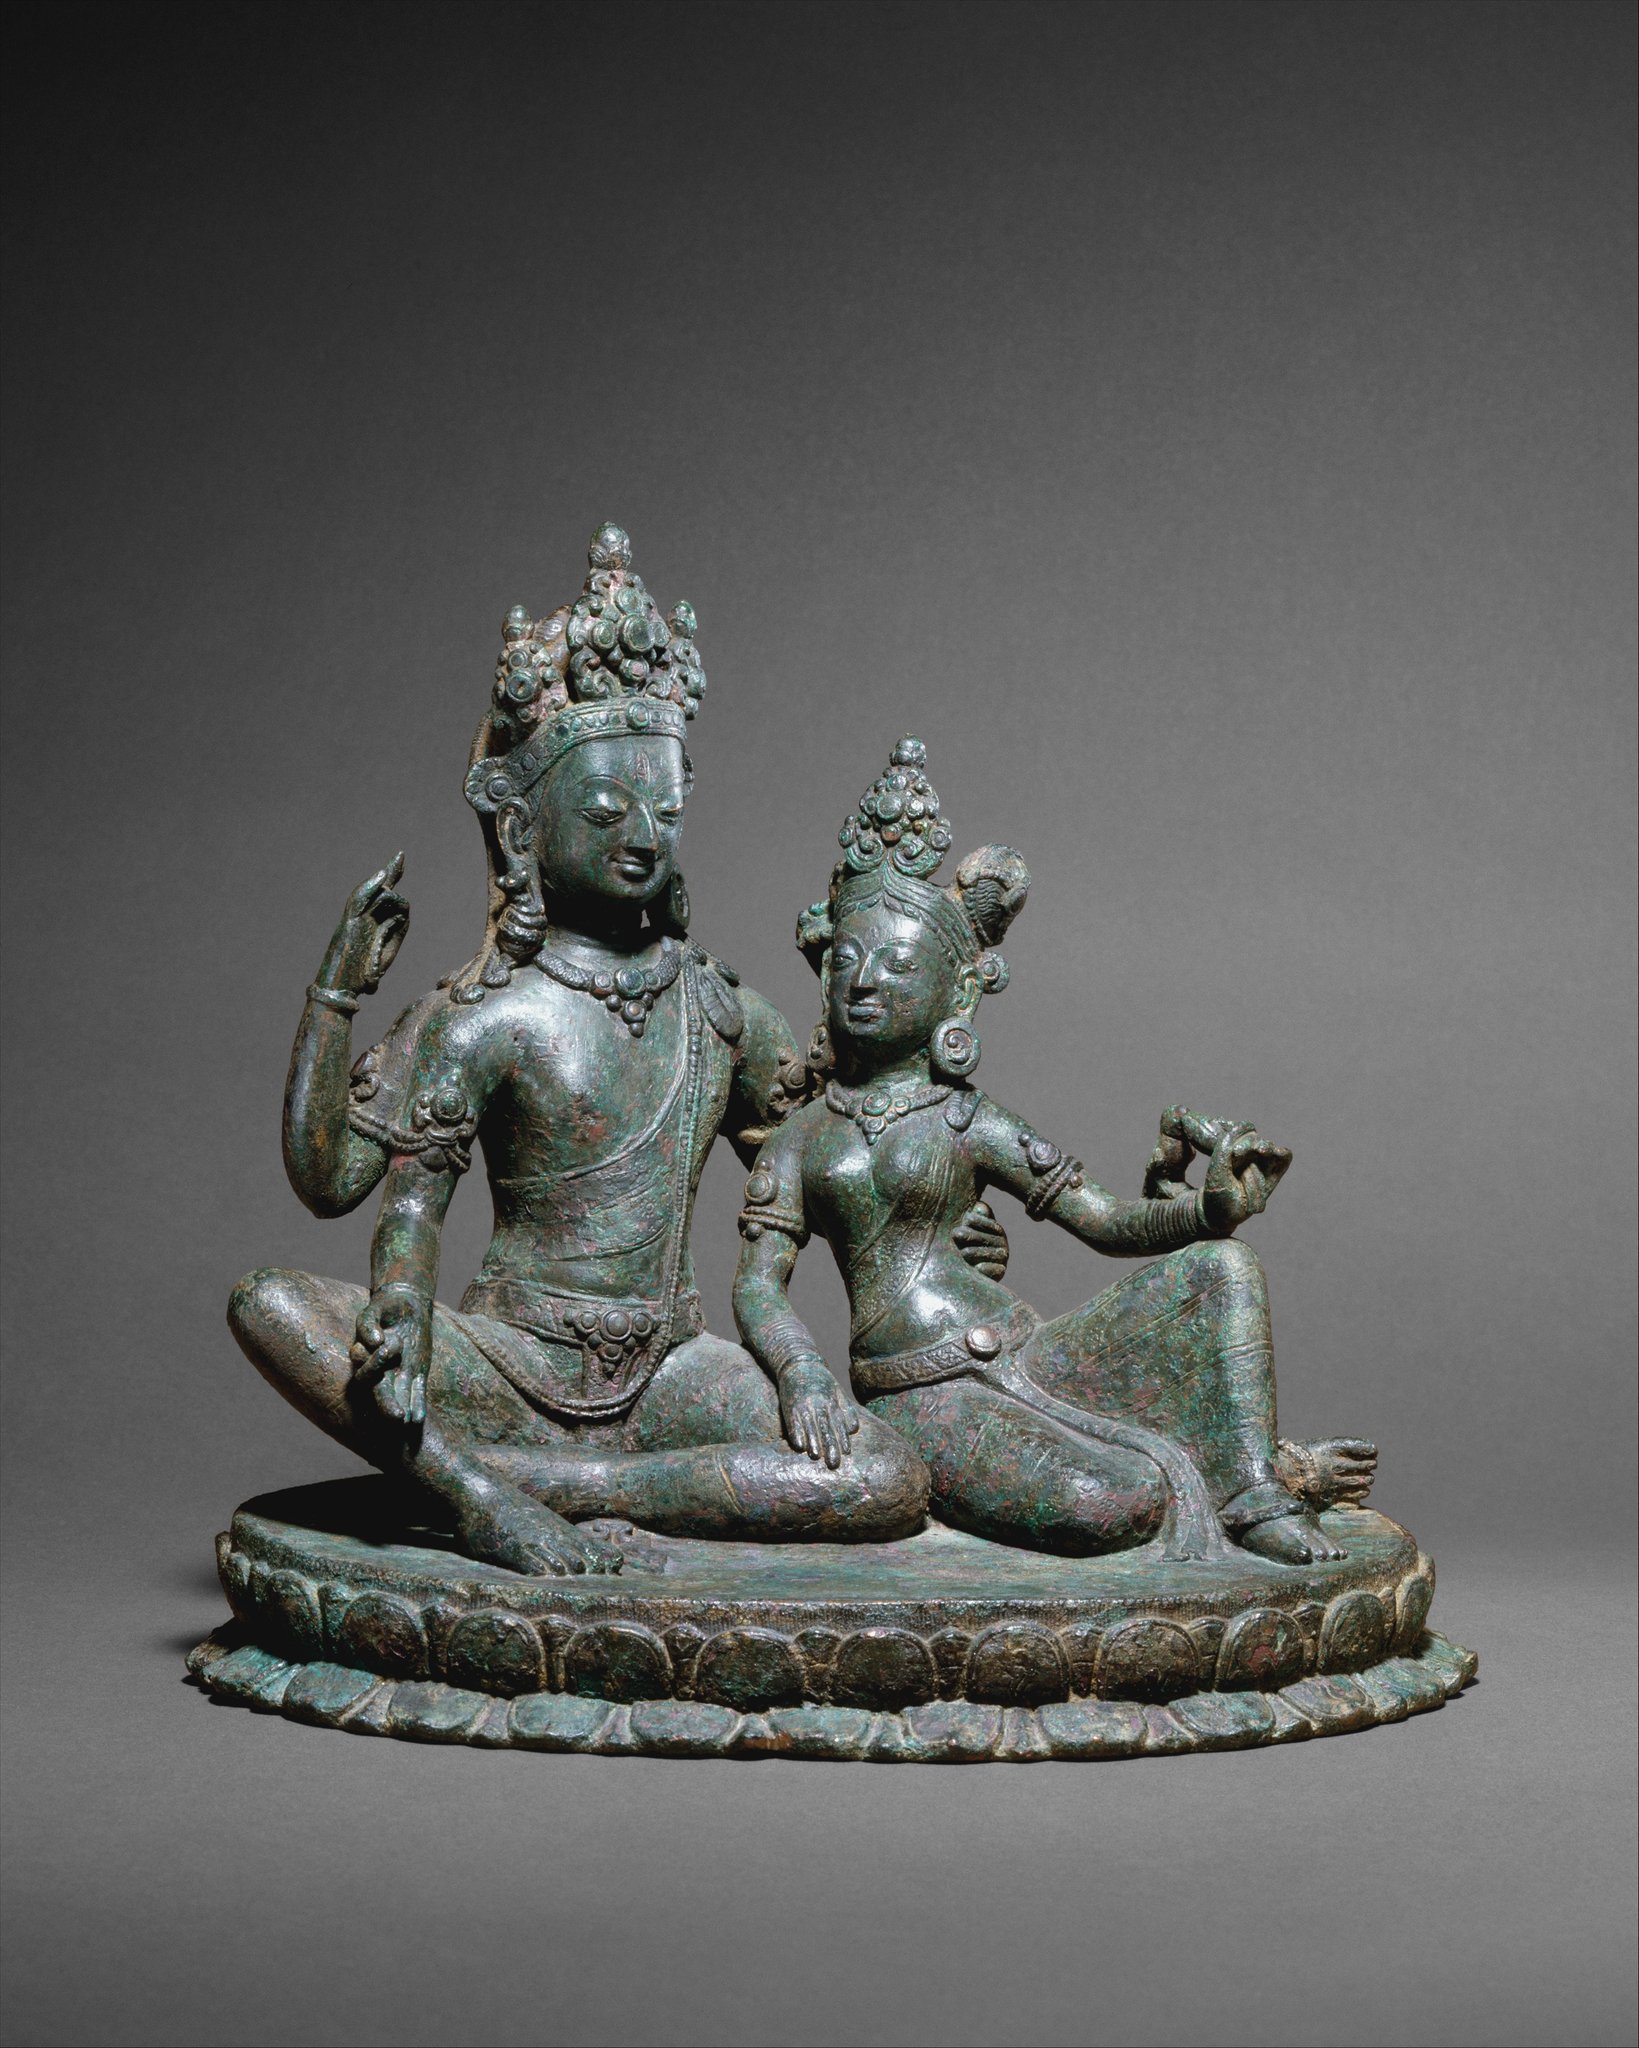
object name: statuette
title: Shiva Seated with Parvati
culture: nepali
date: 1001-1100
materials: copper alloy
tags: couples,parvati,shiva